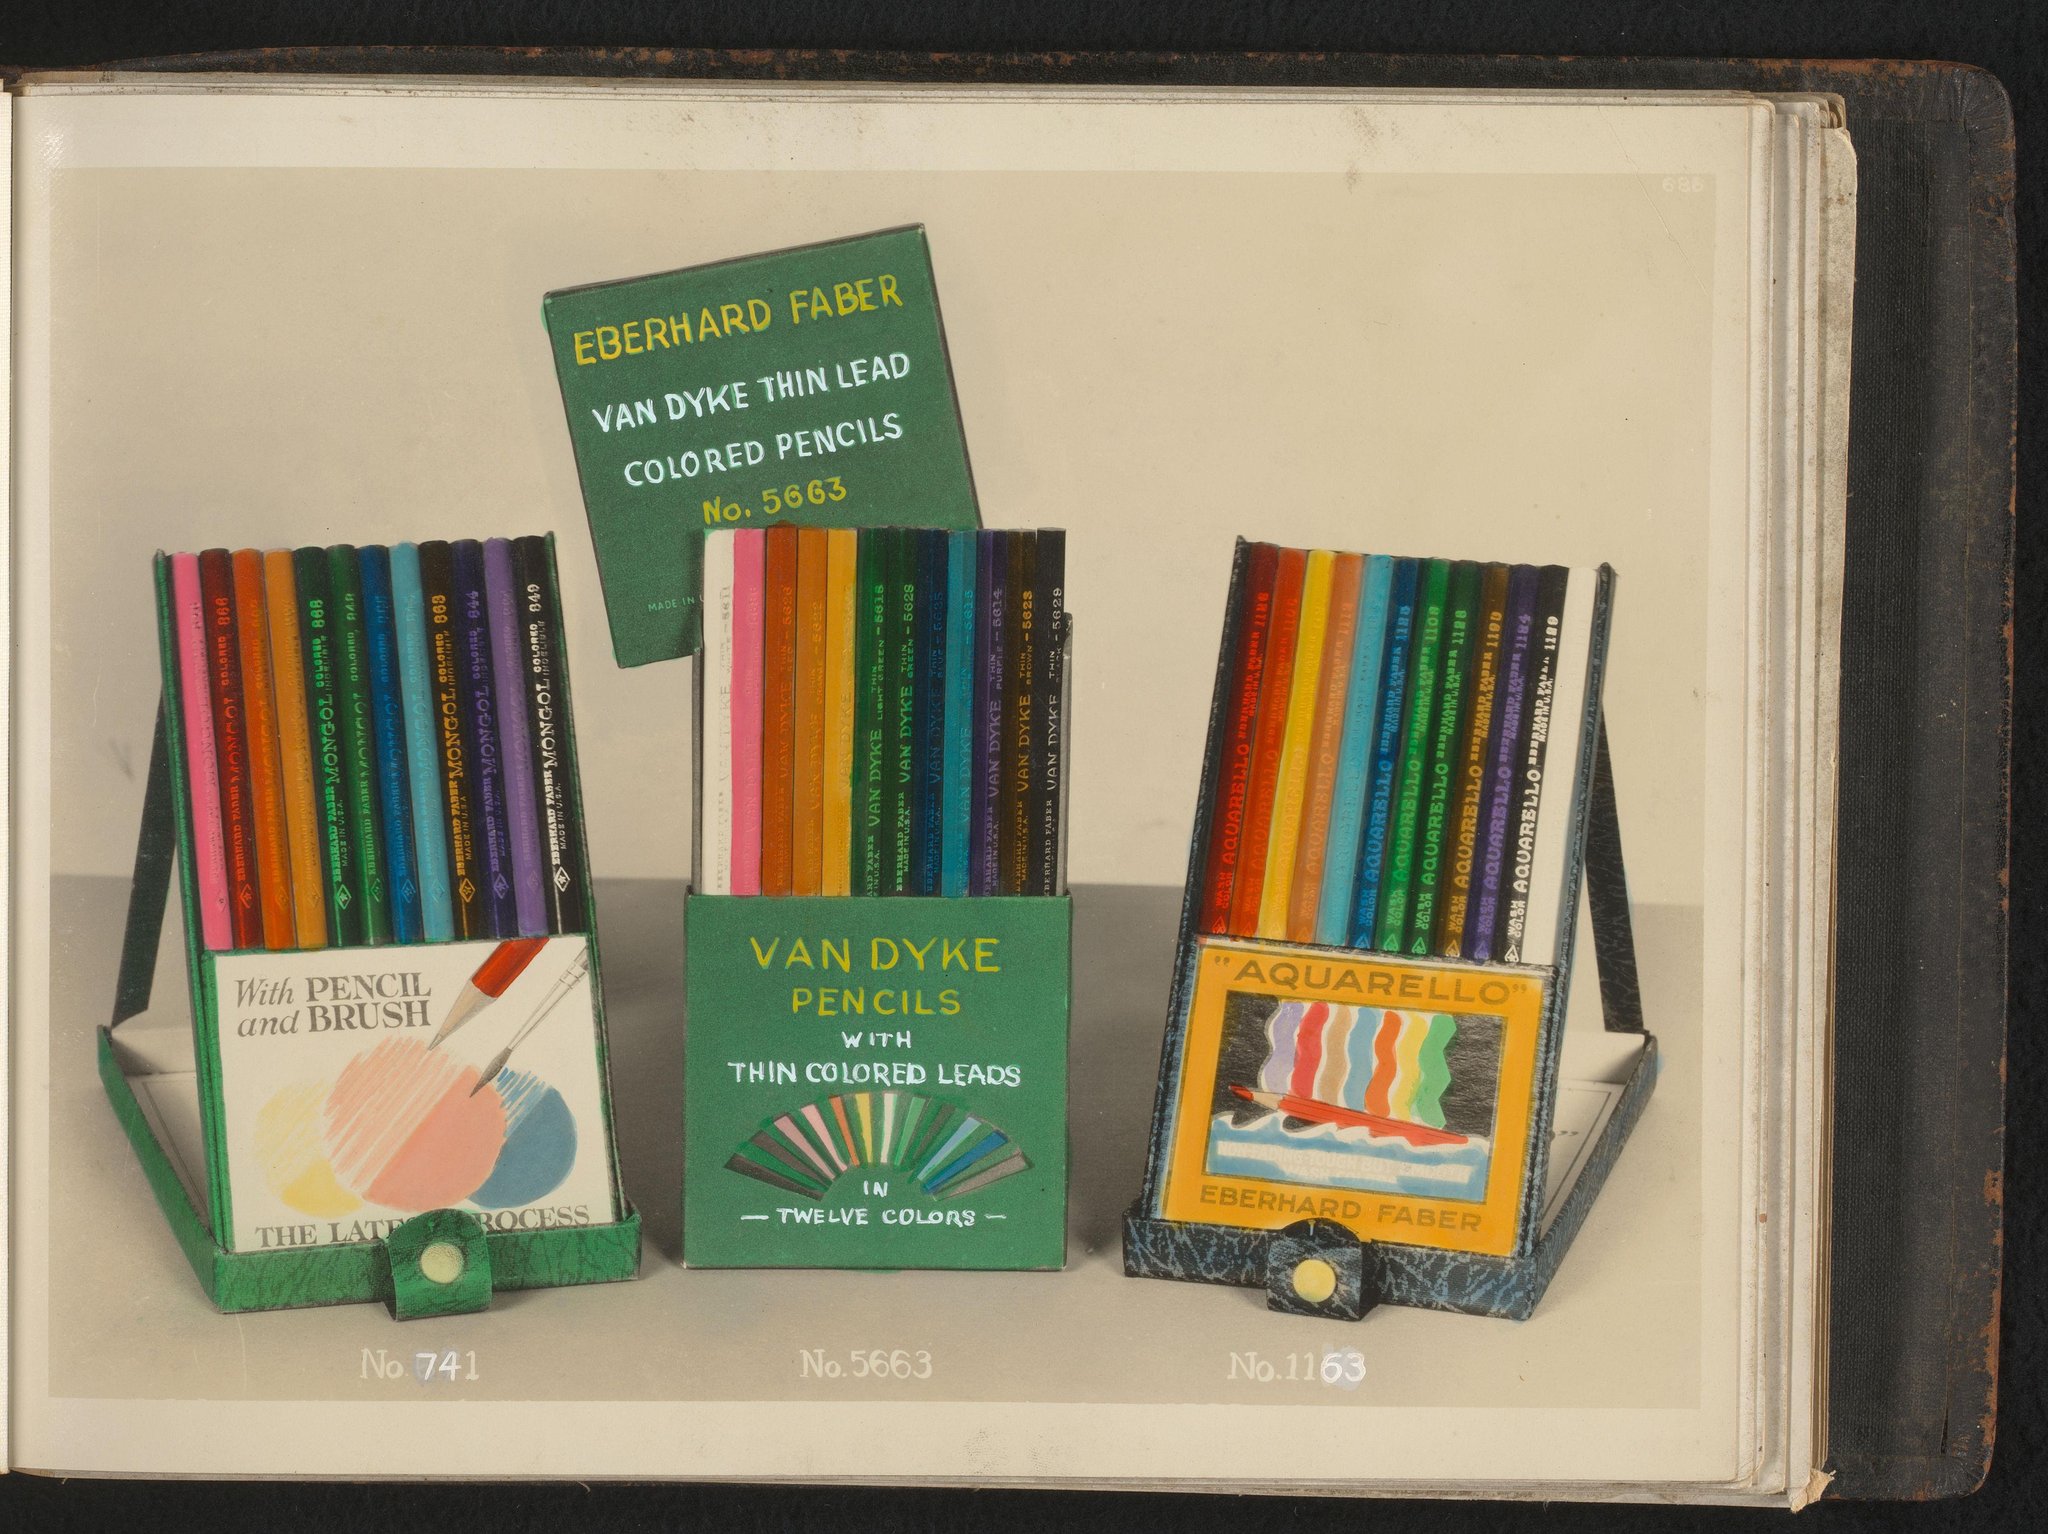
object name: album leaf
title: Sets met kleurpotloden van Eberhard Faber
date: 1915-1935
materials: paper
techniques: gelatin silver print, hand coloring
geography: springfield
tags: pencil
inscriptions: stamp: ‘Paramount/ Commercial Studios/ 145 Chestnut St./ Springfield - Mass.’, number: ‘686’